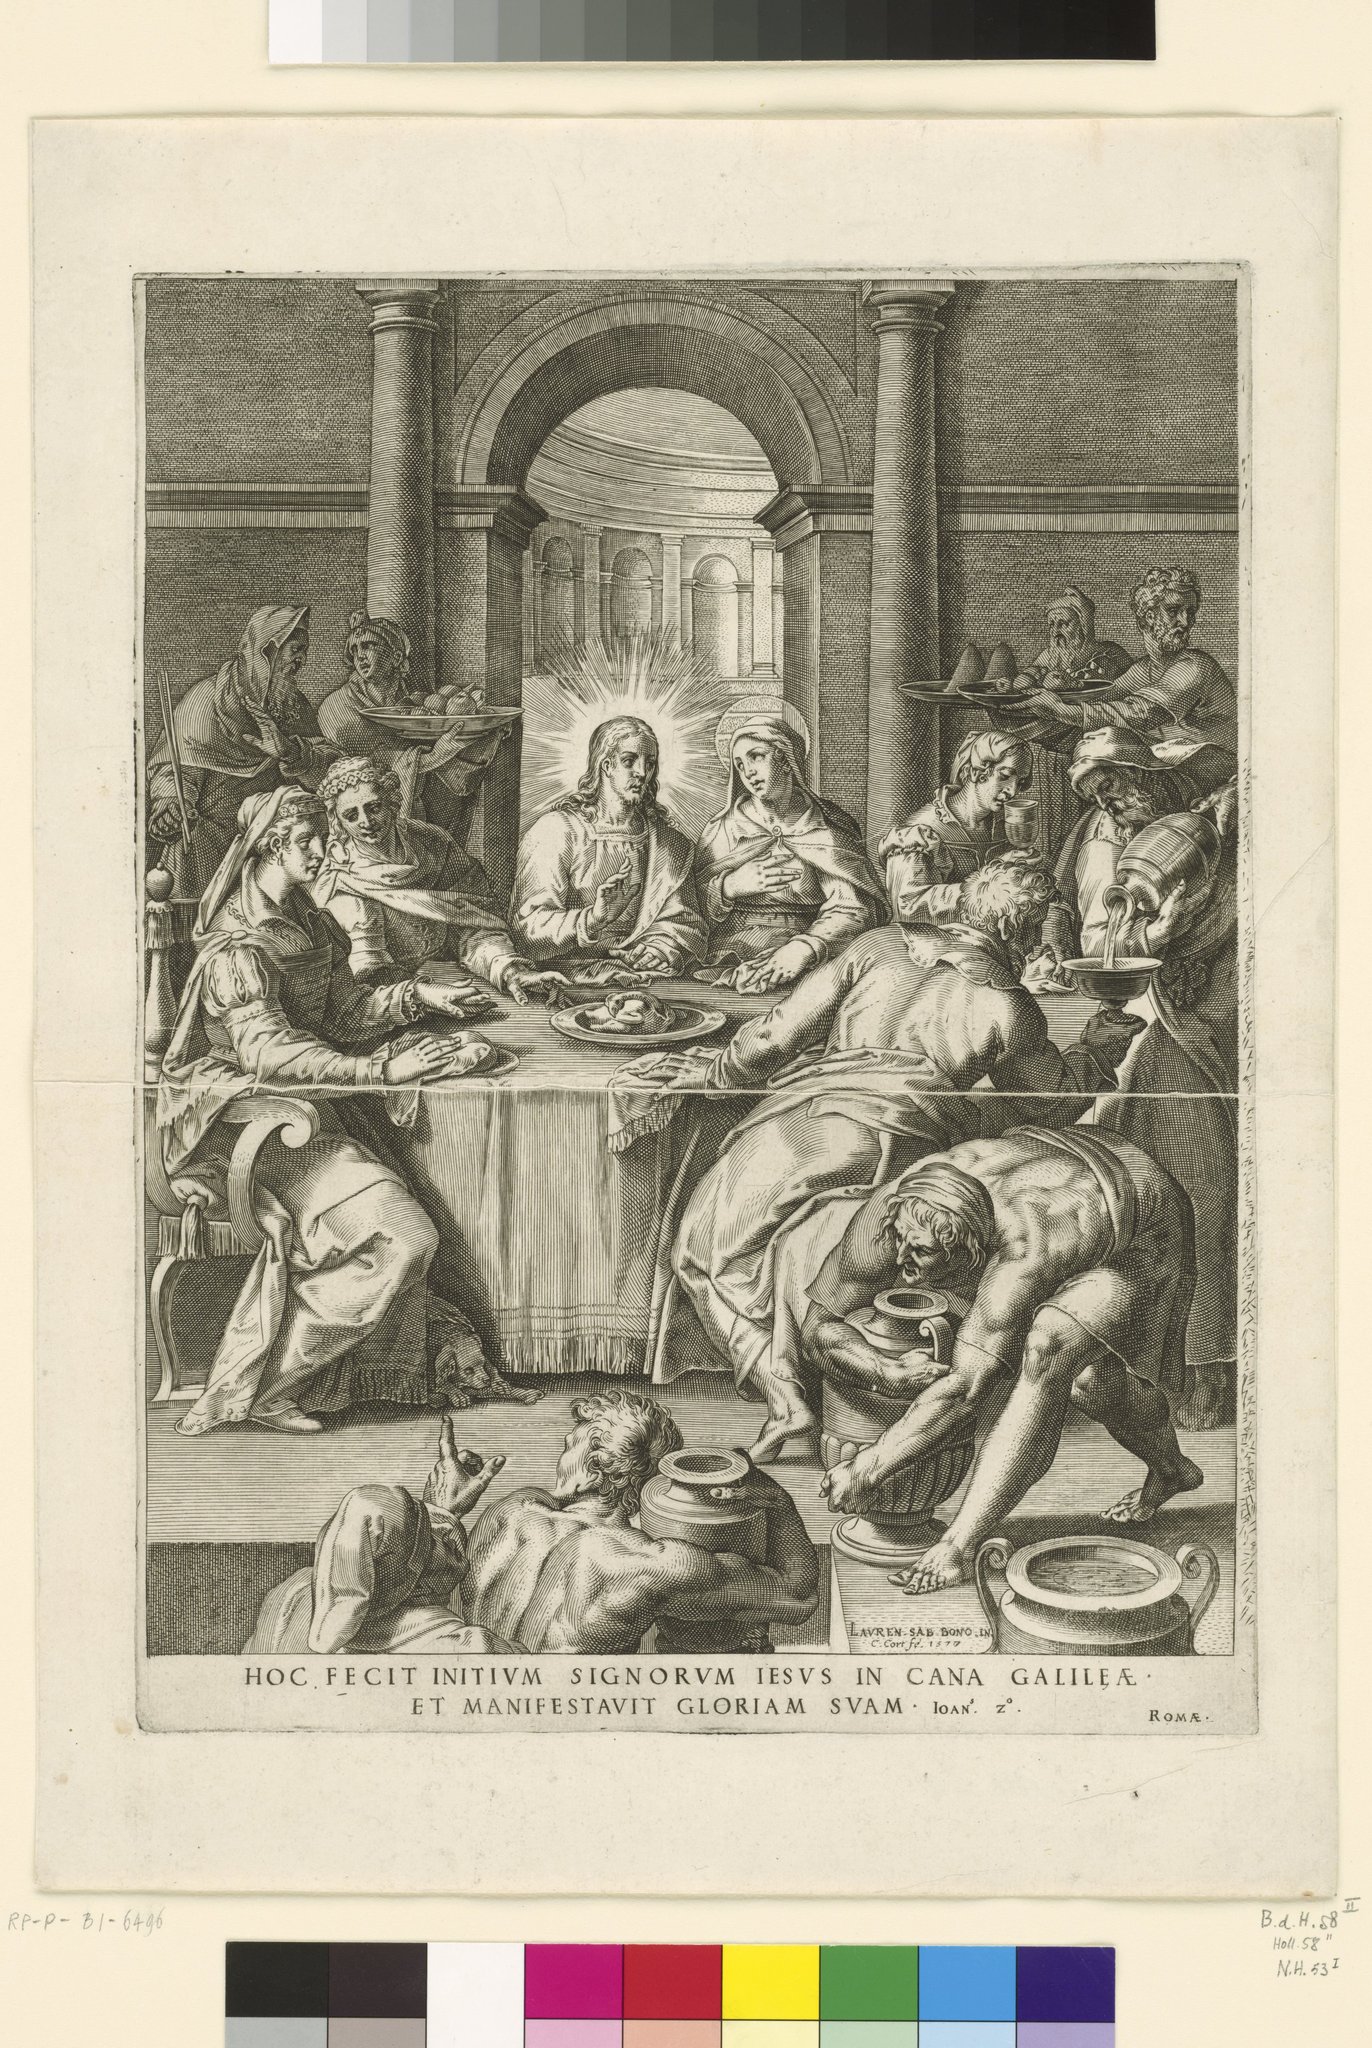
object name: print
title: Bruiloft te Kana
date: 1577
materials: paper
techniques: engraving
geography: rome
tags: the marriage-feast at cana (john 2:1-11), the wine is tested ~ marriage-feast at cana, wine-steward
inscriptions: date: ‘1577’, signature: ‘Lauren Sab(atini) Bono in.’, caption: ‘HOC FECIT INITIUM SIGNORUM IESUS IN CANA GALILEAE / ET MANIFESTAVIT GLORIAM SUAM. Ioan. 2.’, signature: ‘C. Cort fc.’, collector's mark: Lugt 240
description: Christus zit met Maria naast zich aan een tafel. Links zitten twee vrouwen, rechts een vrouw die uit een beker drinkt. Op de voorgrond worden kruiken wijn uit de kelder aangedragen. Rechts zit een man op de rug gezien die de wijn keurt. Door een boogvormige opening met zuilen gezicht in een tweede ruimte.